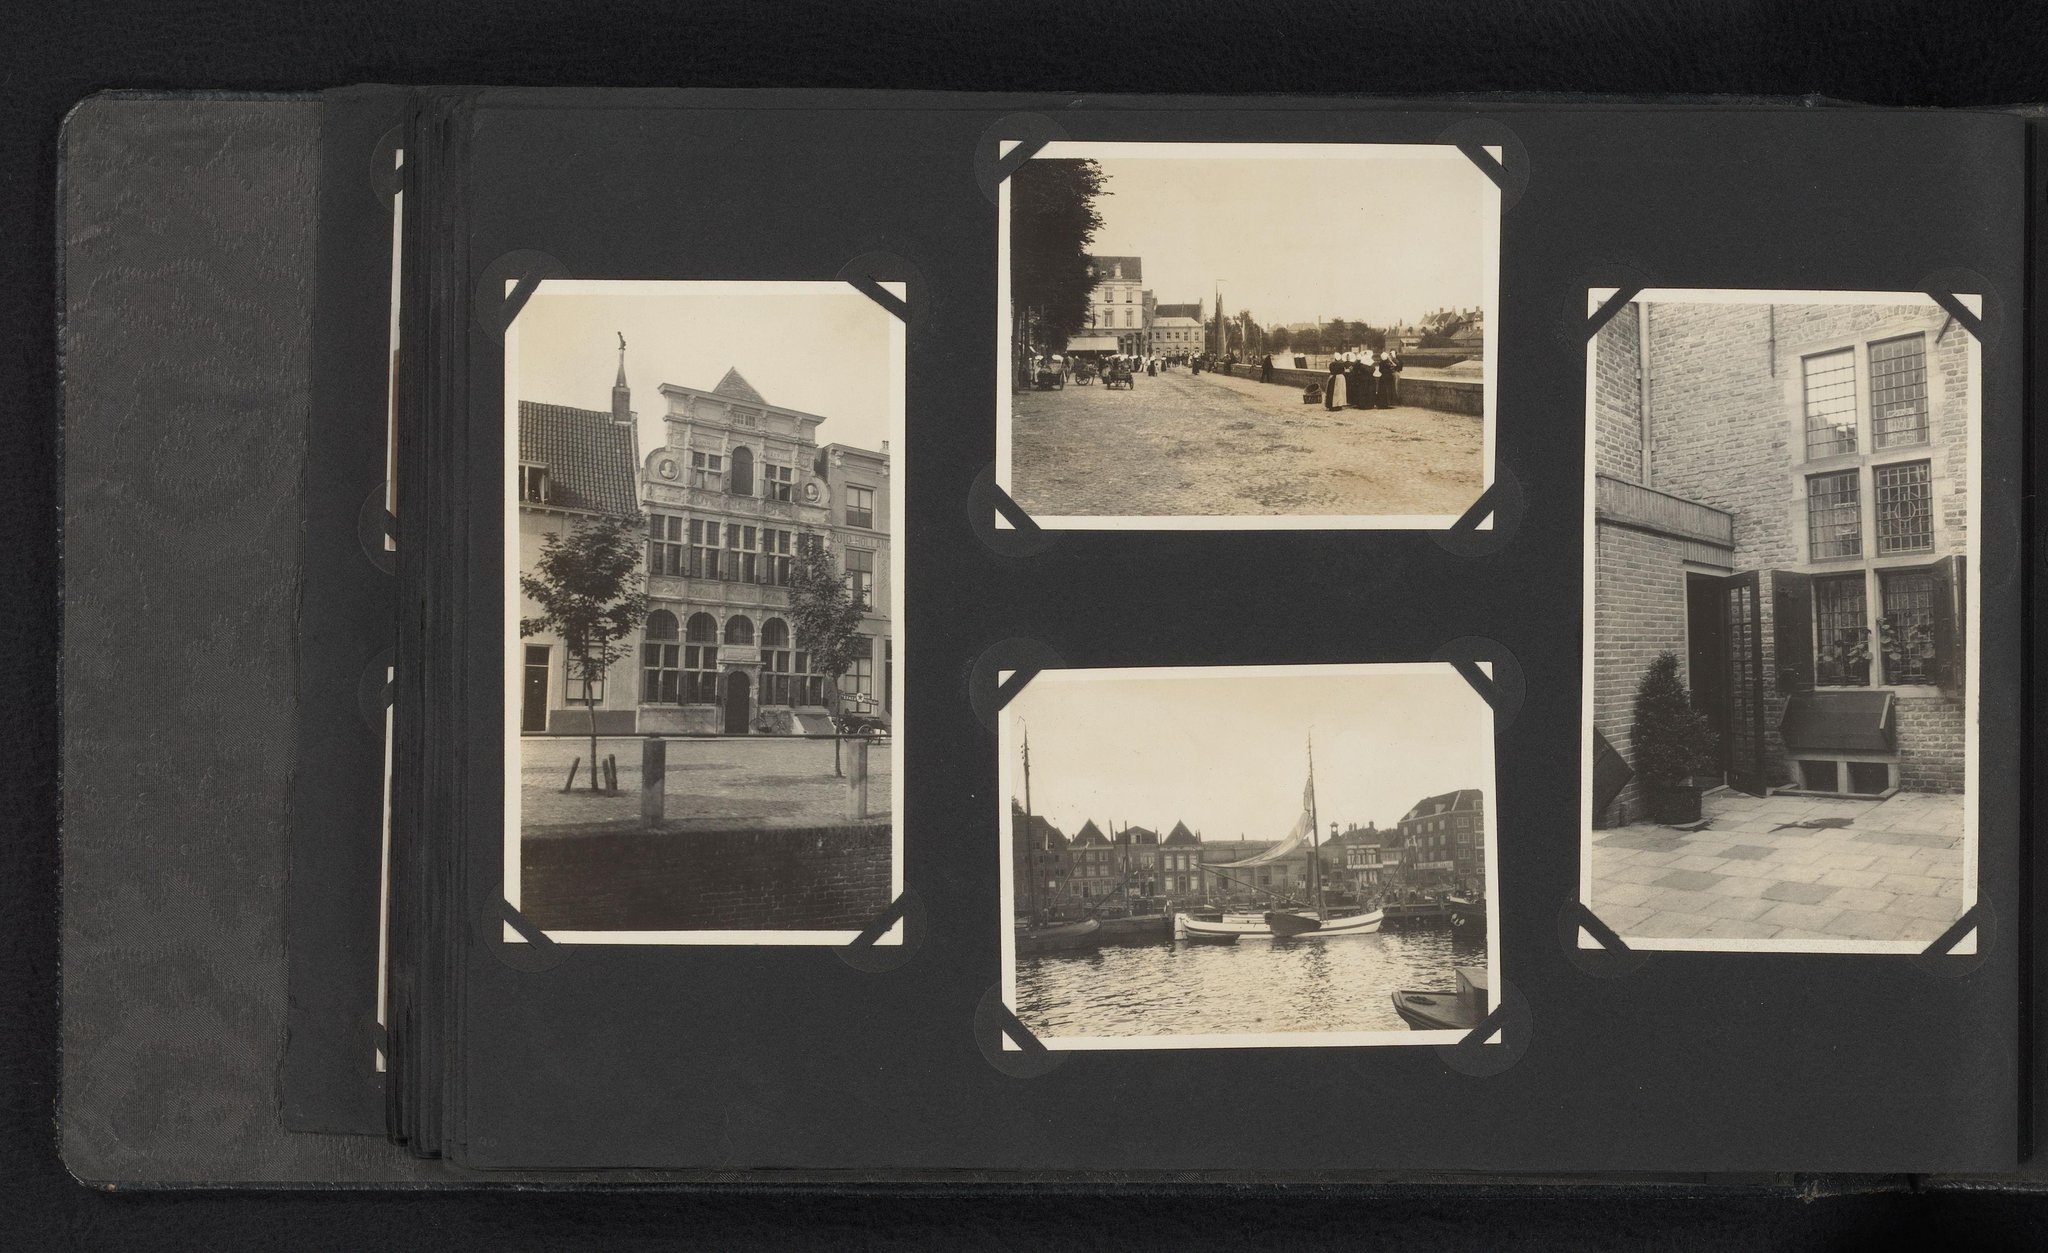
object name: photograph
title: Vier foto's van zeilboot De Snits en huizen in Nederland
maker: hendrik herman van den berg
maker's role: amateurfotograaf, jurist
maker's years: 1875-1944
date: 1926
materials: paper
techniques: gelatin silver print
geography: netherlands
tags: urban housing, sailing-ship, sailing-boat, netherlands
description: Deze foto's maken deel uit van een album.